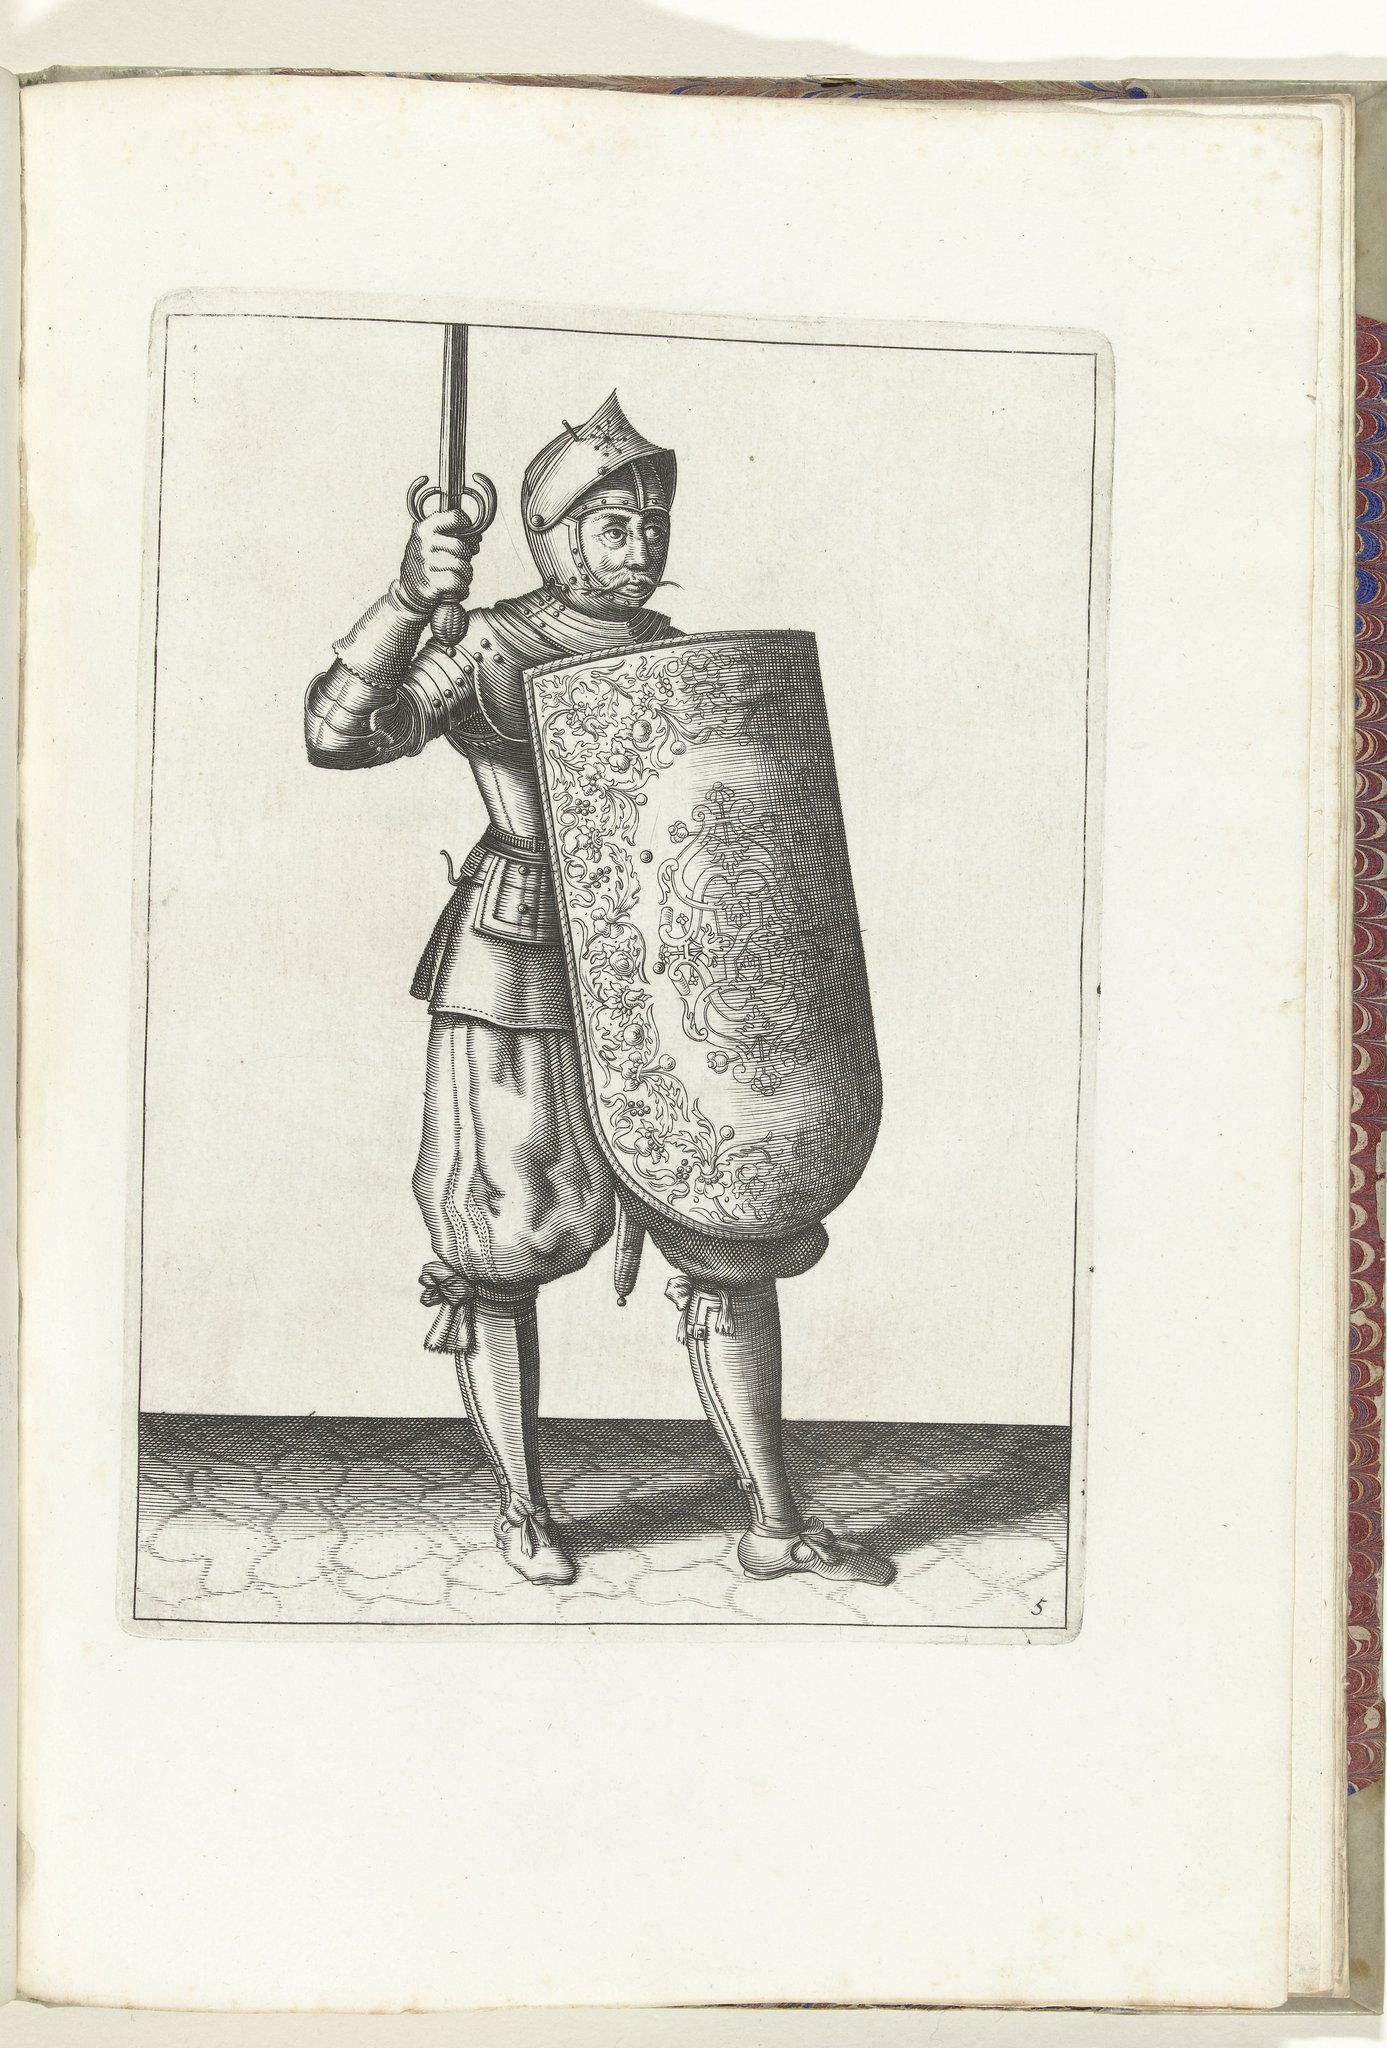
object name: print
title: De exercitie met de targe en rapier: de soldaat houdt de getrokken rapier niet hoger dan zijn gezicht (nr. 5), 1618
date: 1616-1618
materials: paper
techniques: engraving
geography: northern netherlands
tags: the hague, maurice (prince of orange), handling of weapons ~ military training, weapons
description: Illustratie in: Adam van Breen, De Nassausche Wapen-Handelinge, van Schilt, Spies, Rappier ende Targe : beyde figuerlick afgebeelt, ende gestelt na de nieu ordening [van] ... Maurits van Nassau / Korte Onderwijsinge op de figuerlijcke af-beeldinghe belangende 'trecht ghebruyck van al 'tghene een Soldaet noodigh is in het handelen vande Targes met het Rappier, 's-Gravenhage, [Aert Meuris] 1618, plaat nr. 5. In het exemplaar in de collectie van de Rijksmuseum Research Library (326 F 22).